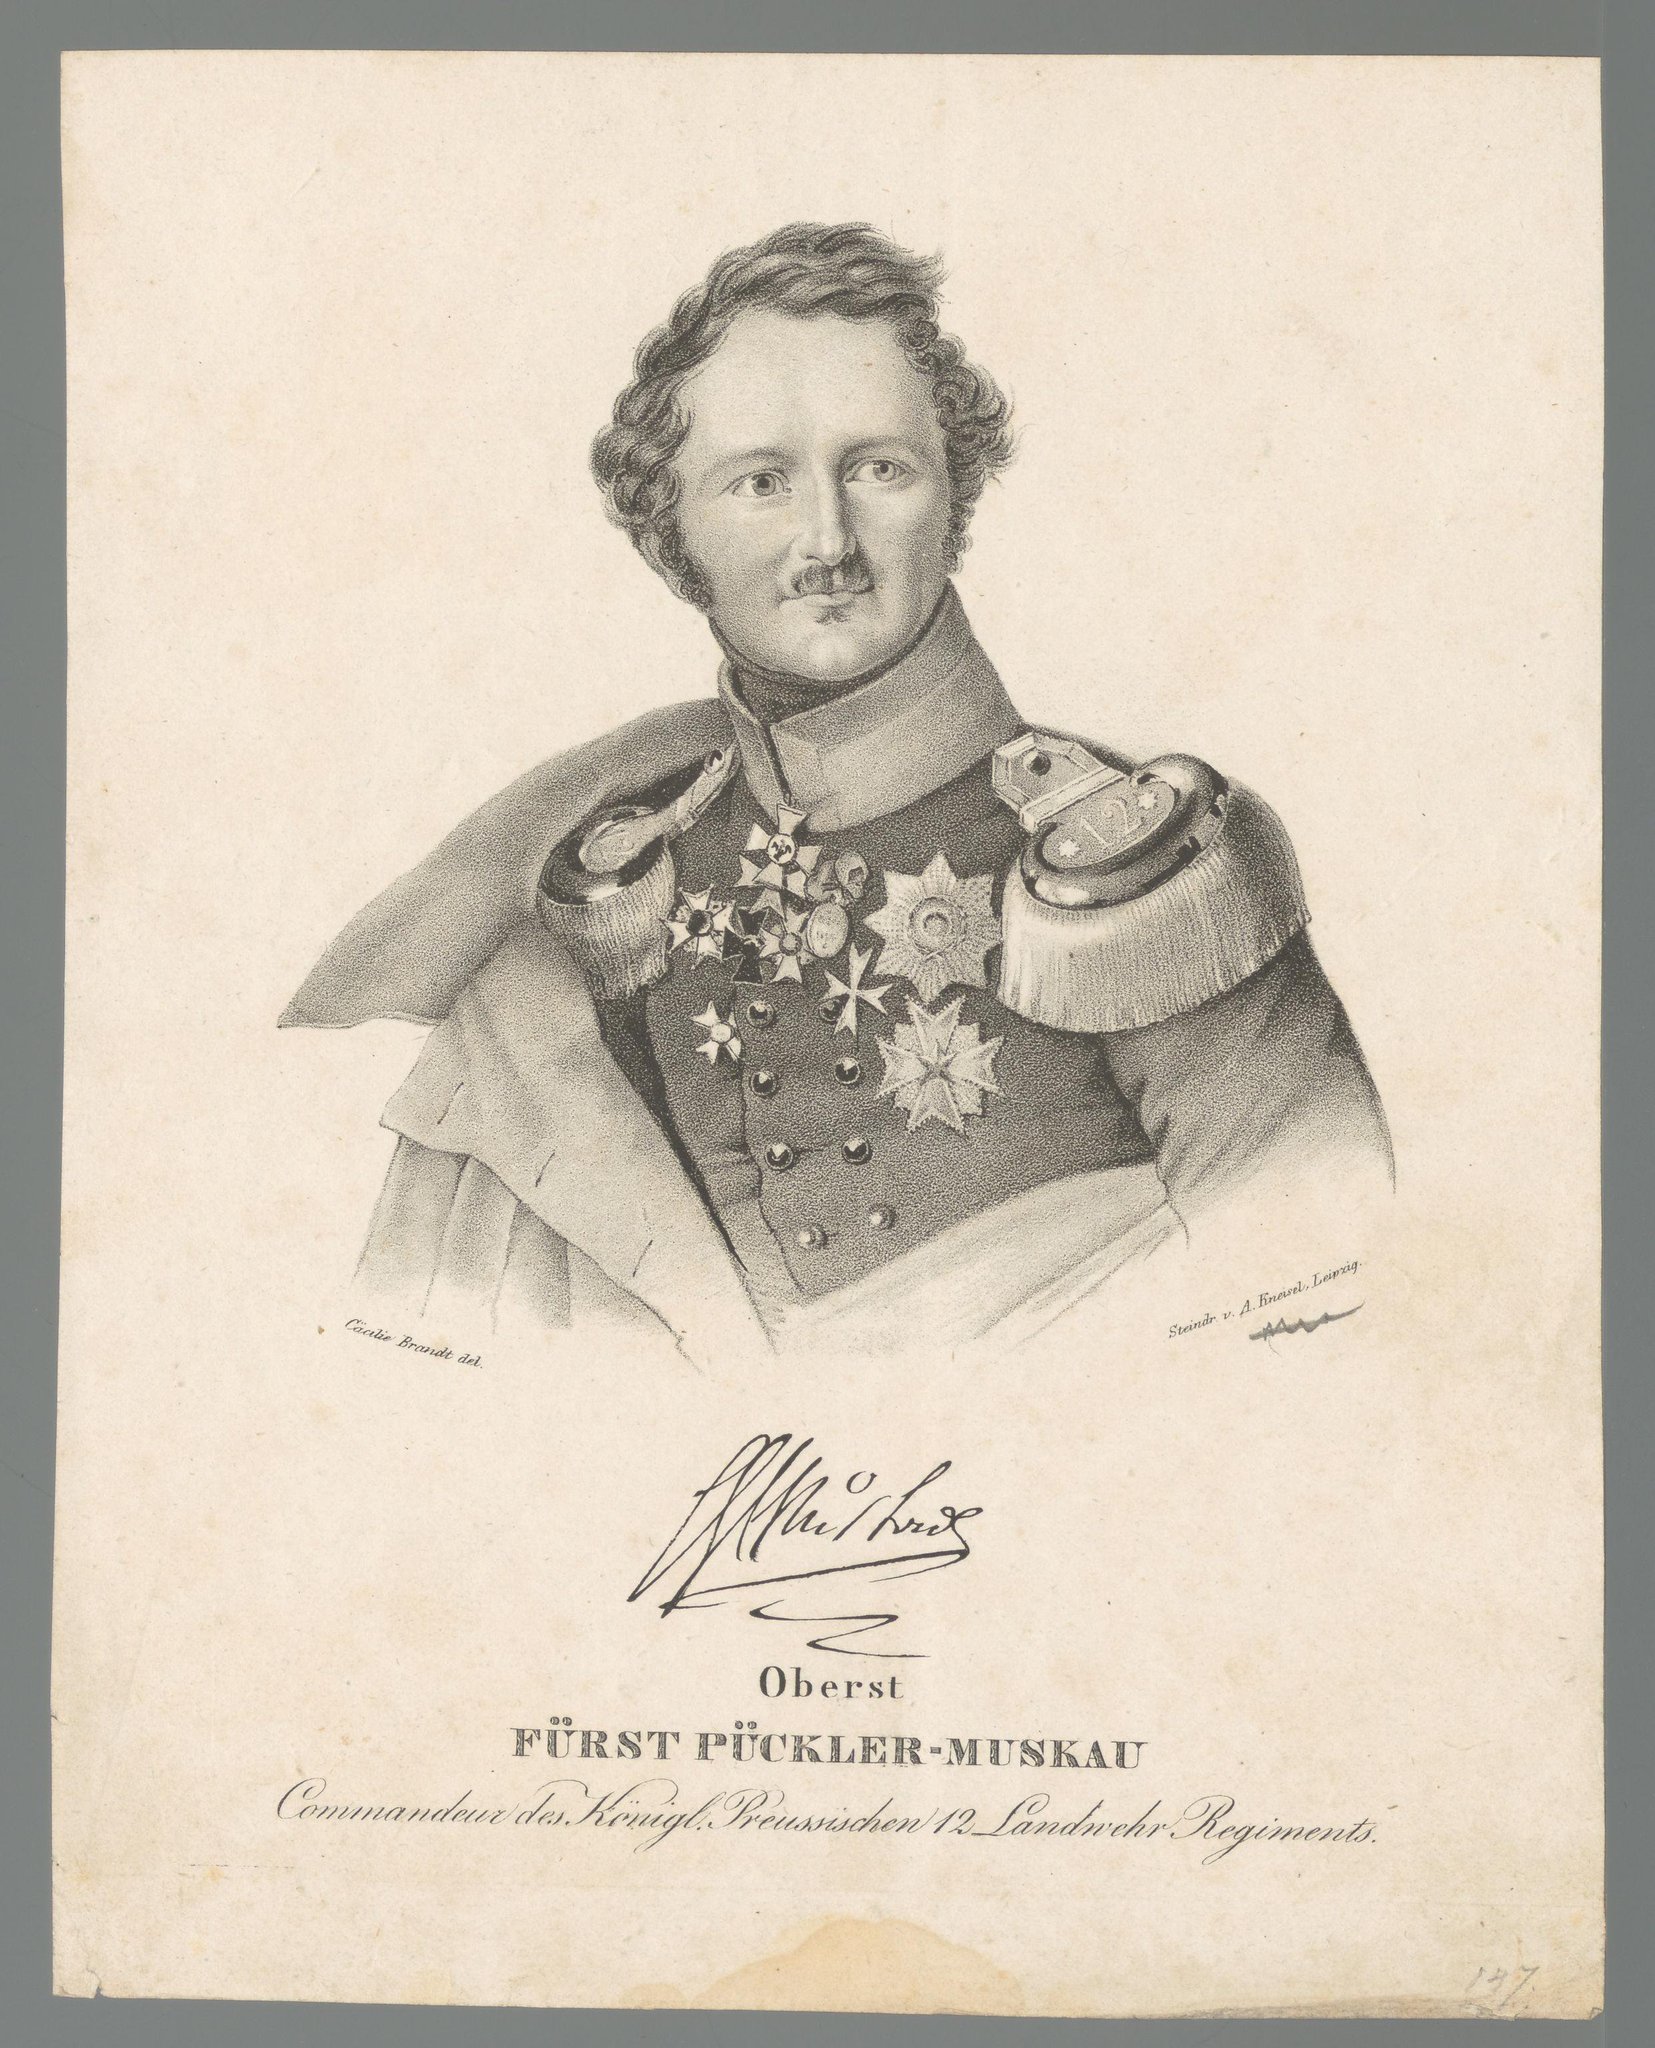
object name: print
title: Oberst Fürst Pückler-Muskau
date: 1825-1850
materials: paper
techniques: lithograph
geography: leipzig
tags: adult man, historical persons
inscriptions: collector's mark: Lugt 2228